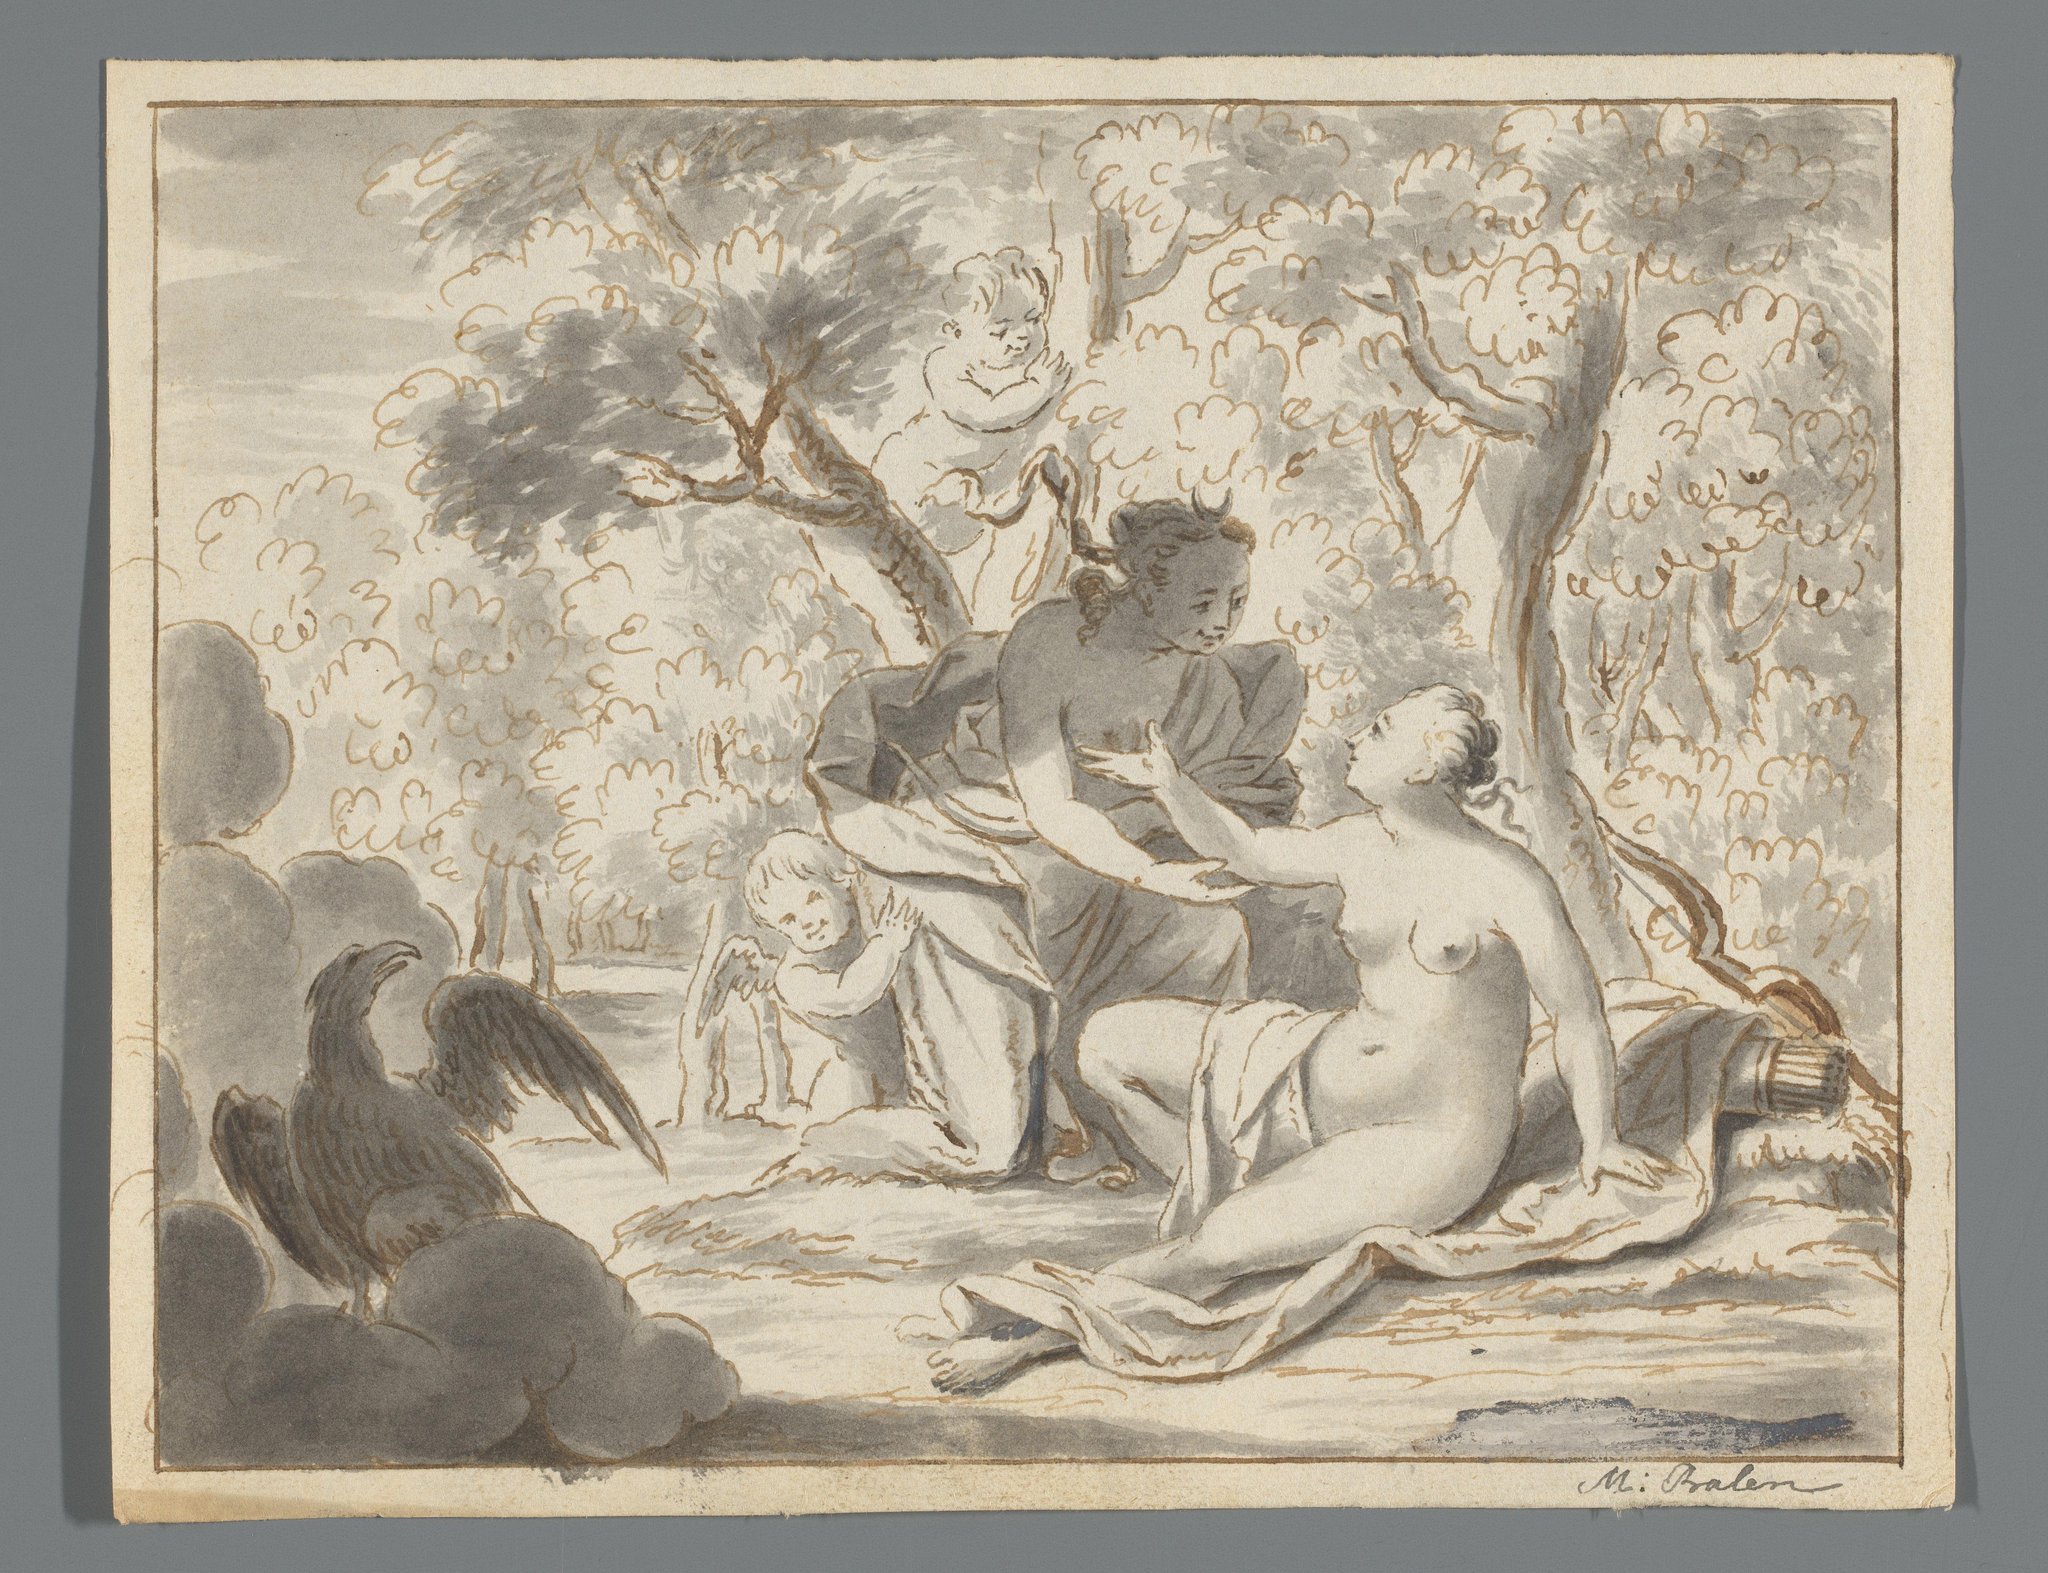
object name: drawing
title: Jupiter, vermomd als Diana, verleidt de nimf Callisto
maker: matthijs balen (1684-1766)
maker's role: draughtsman, painter, print maker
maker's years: 1684-1766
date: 1694-1766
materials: paint, paper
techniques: brush, pen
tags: jupiter, in the guise of diana, and callisto